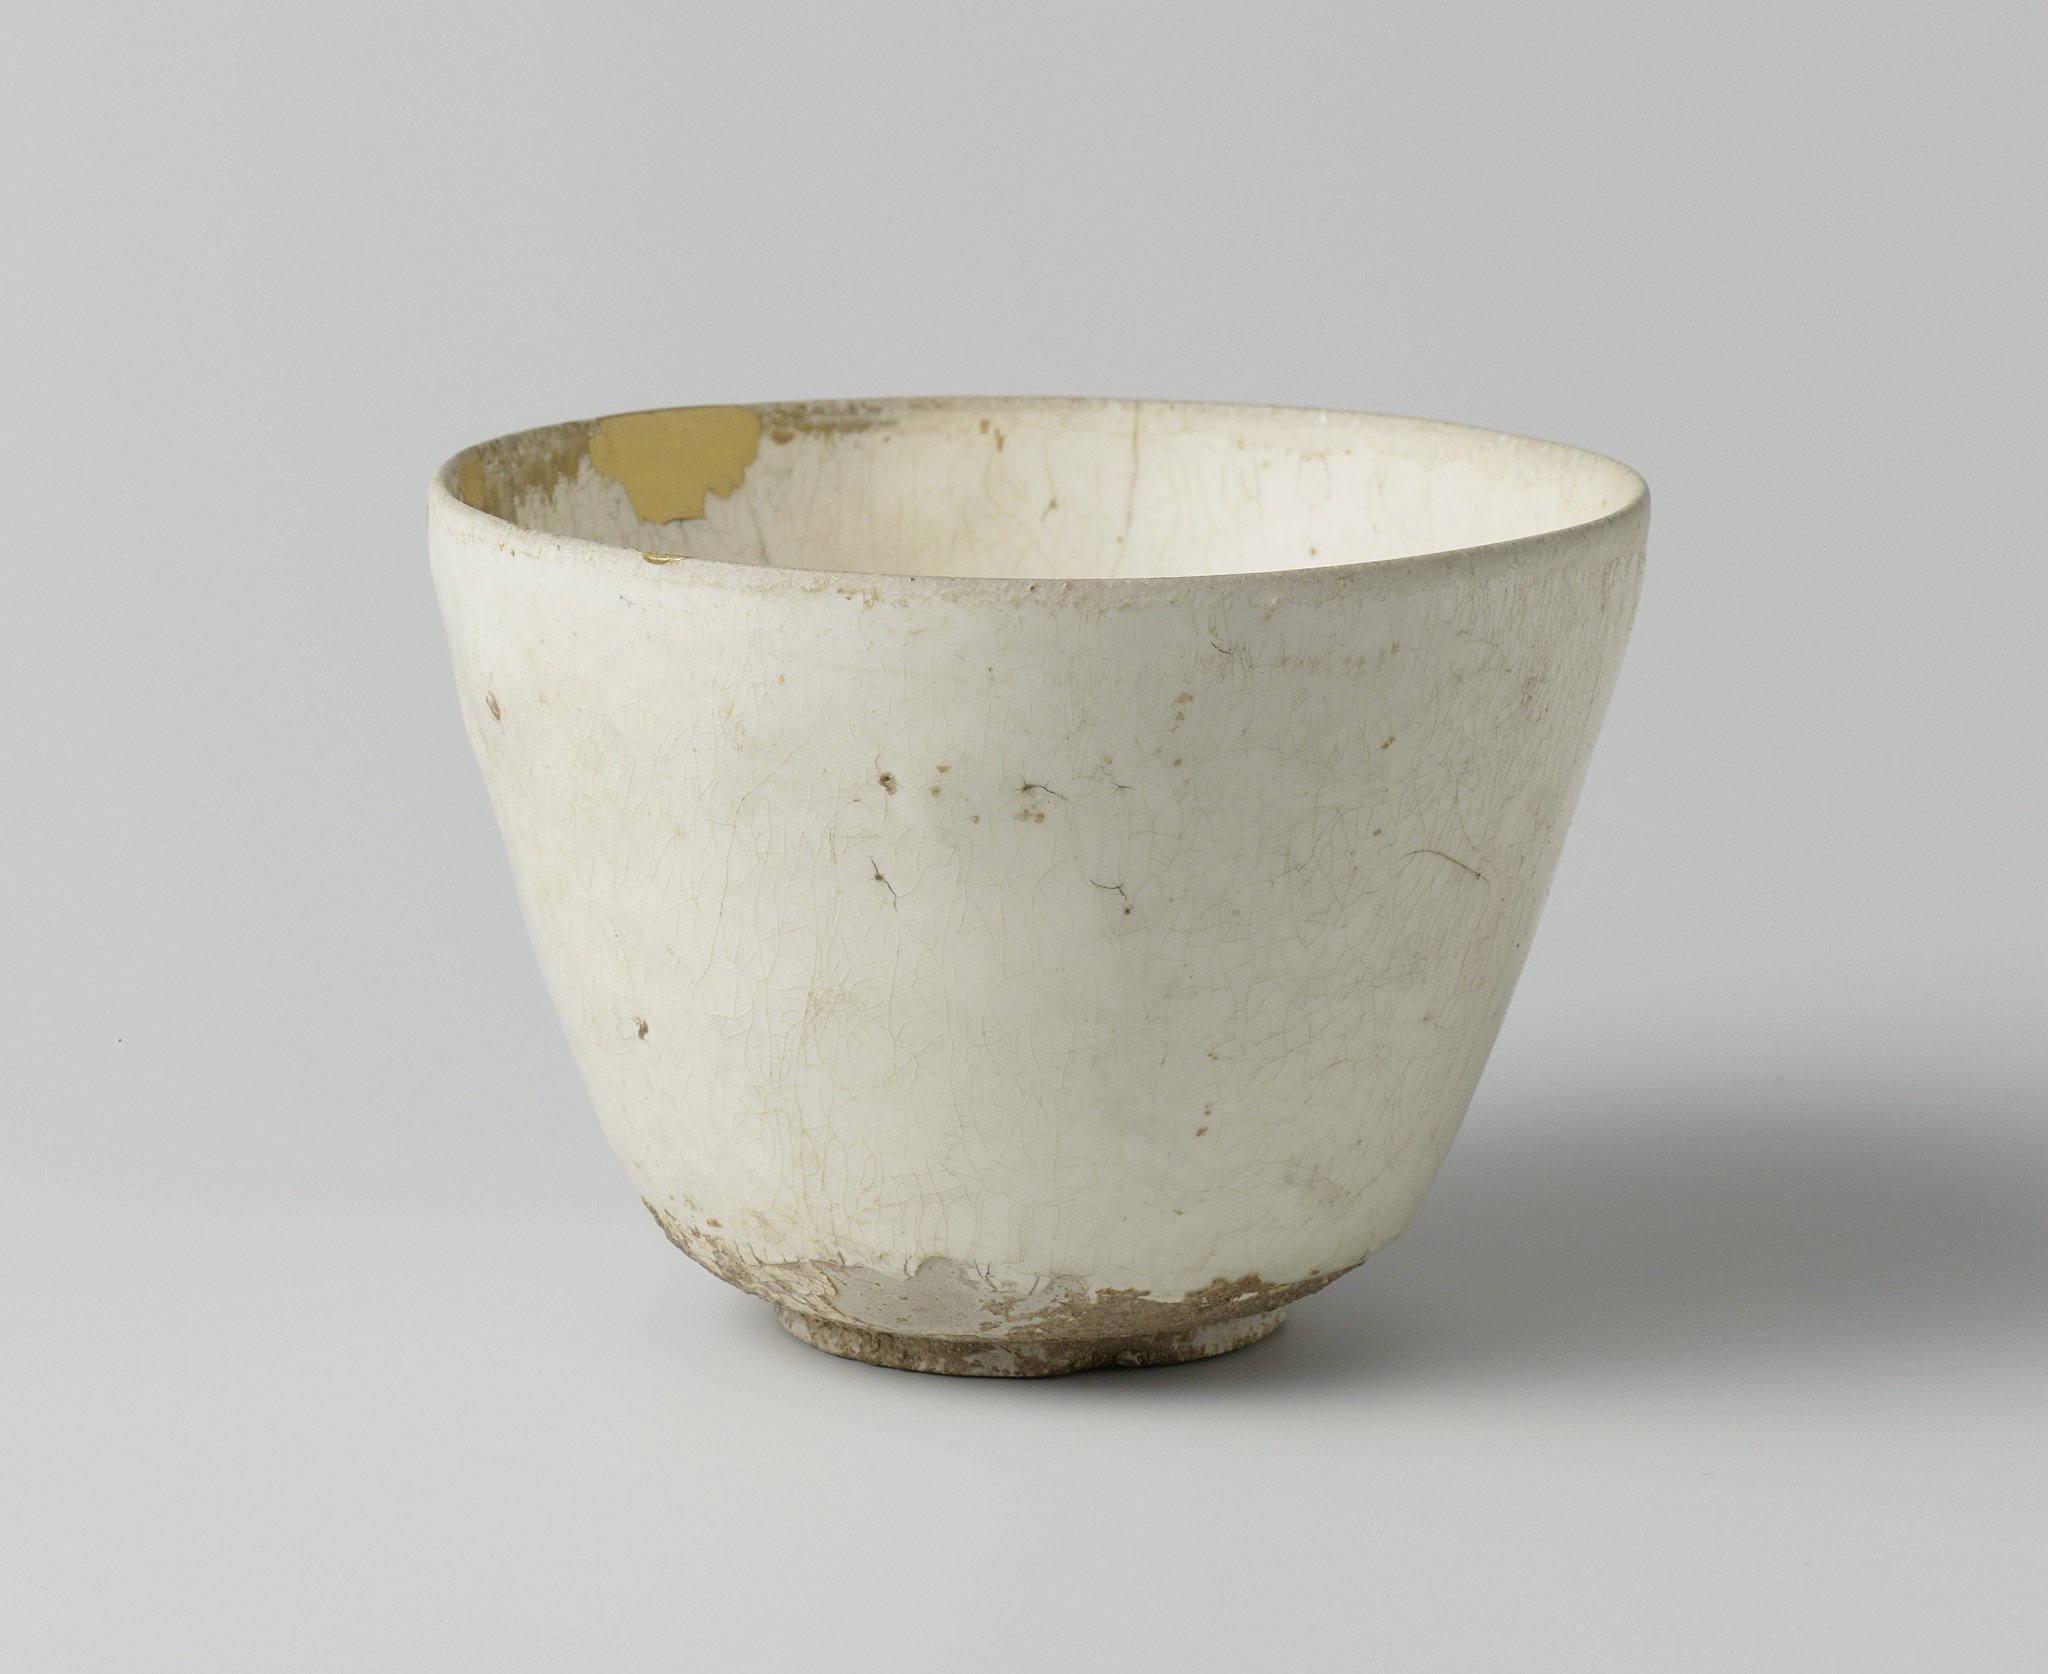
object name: bowl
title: Bowl with three spur marks and a gold laquer repair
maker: Anonymous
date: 1100-1299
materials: glaze, gold, stoneware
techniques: firing, turning, vitrification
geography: china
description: Two pots and a bowl. China. Song period (960 - 1279). Glazed stoneware, Juluxian ware. The grey stoneware produced in the Juluxian kilns of Hebei province in Northern China was made with cream-white or cream-coloured glaze.